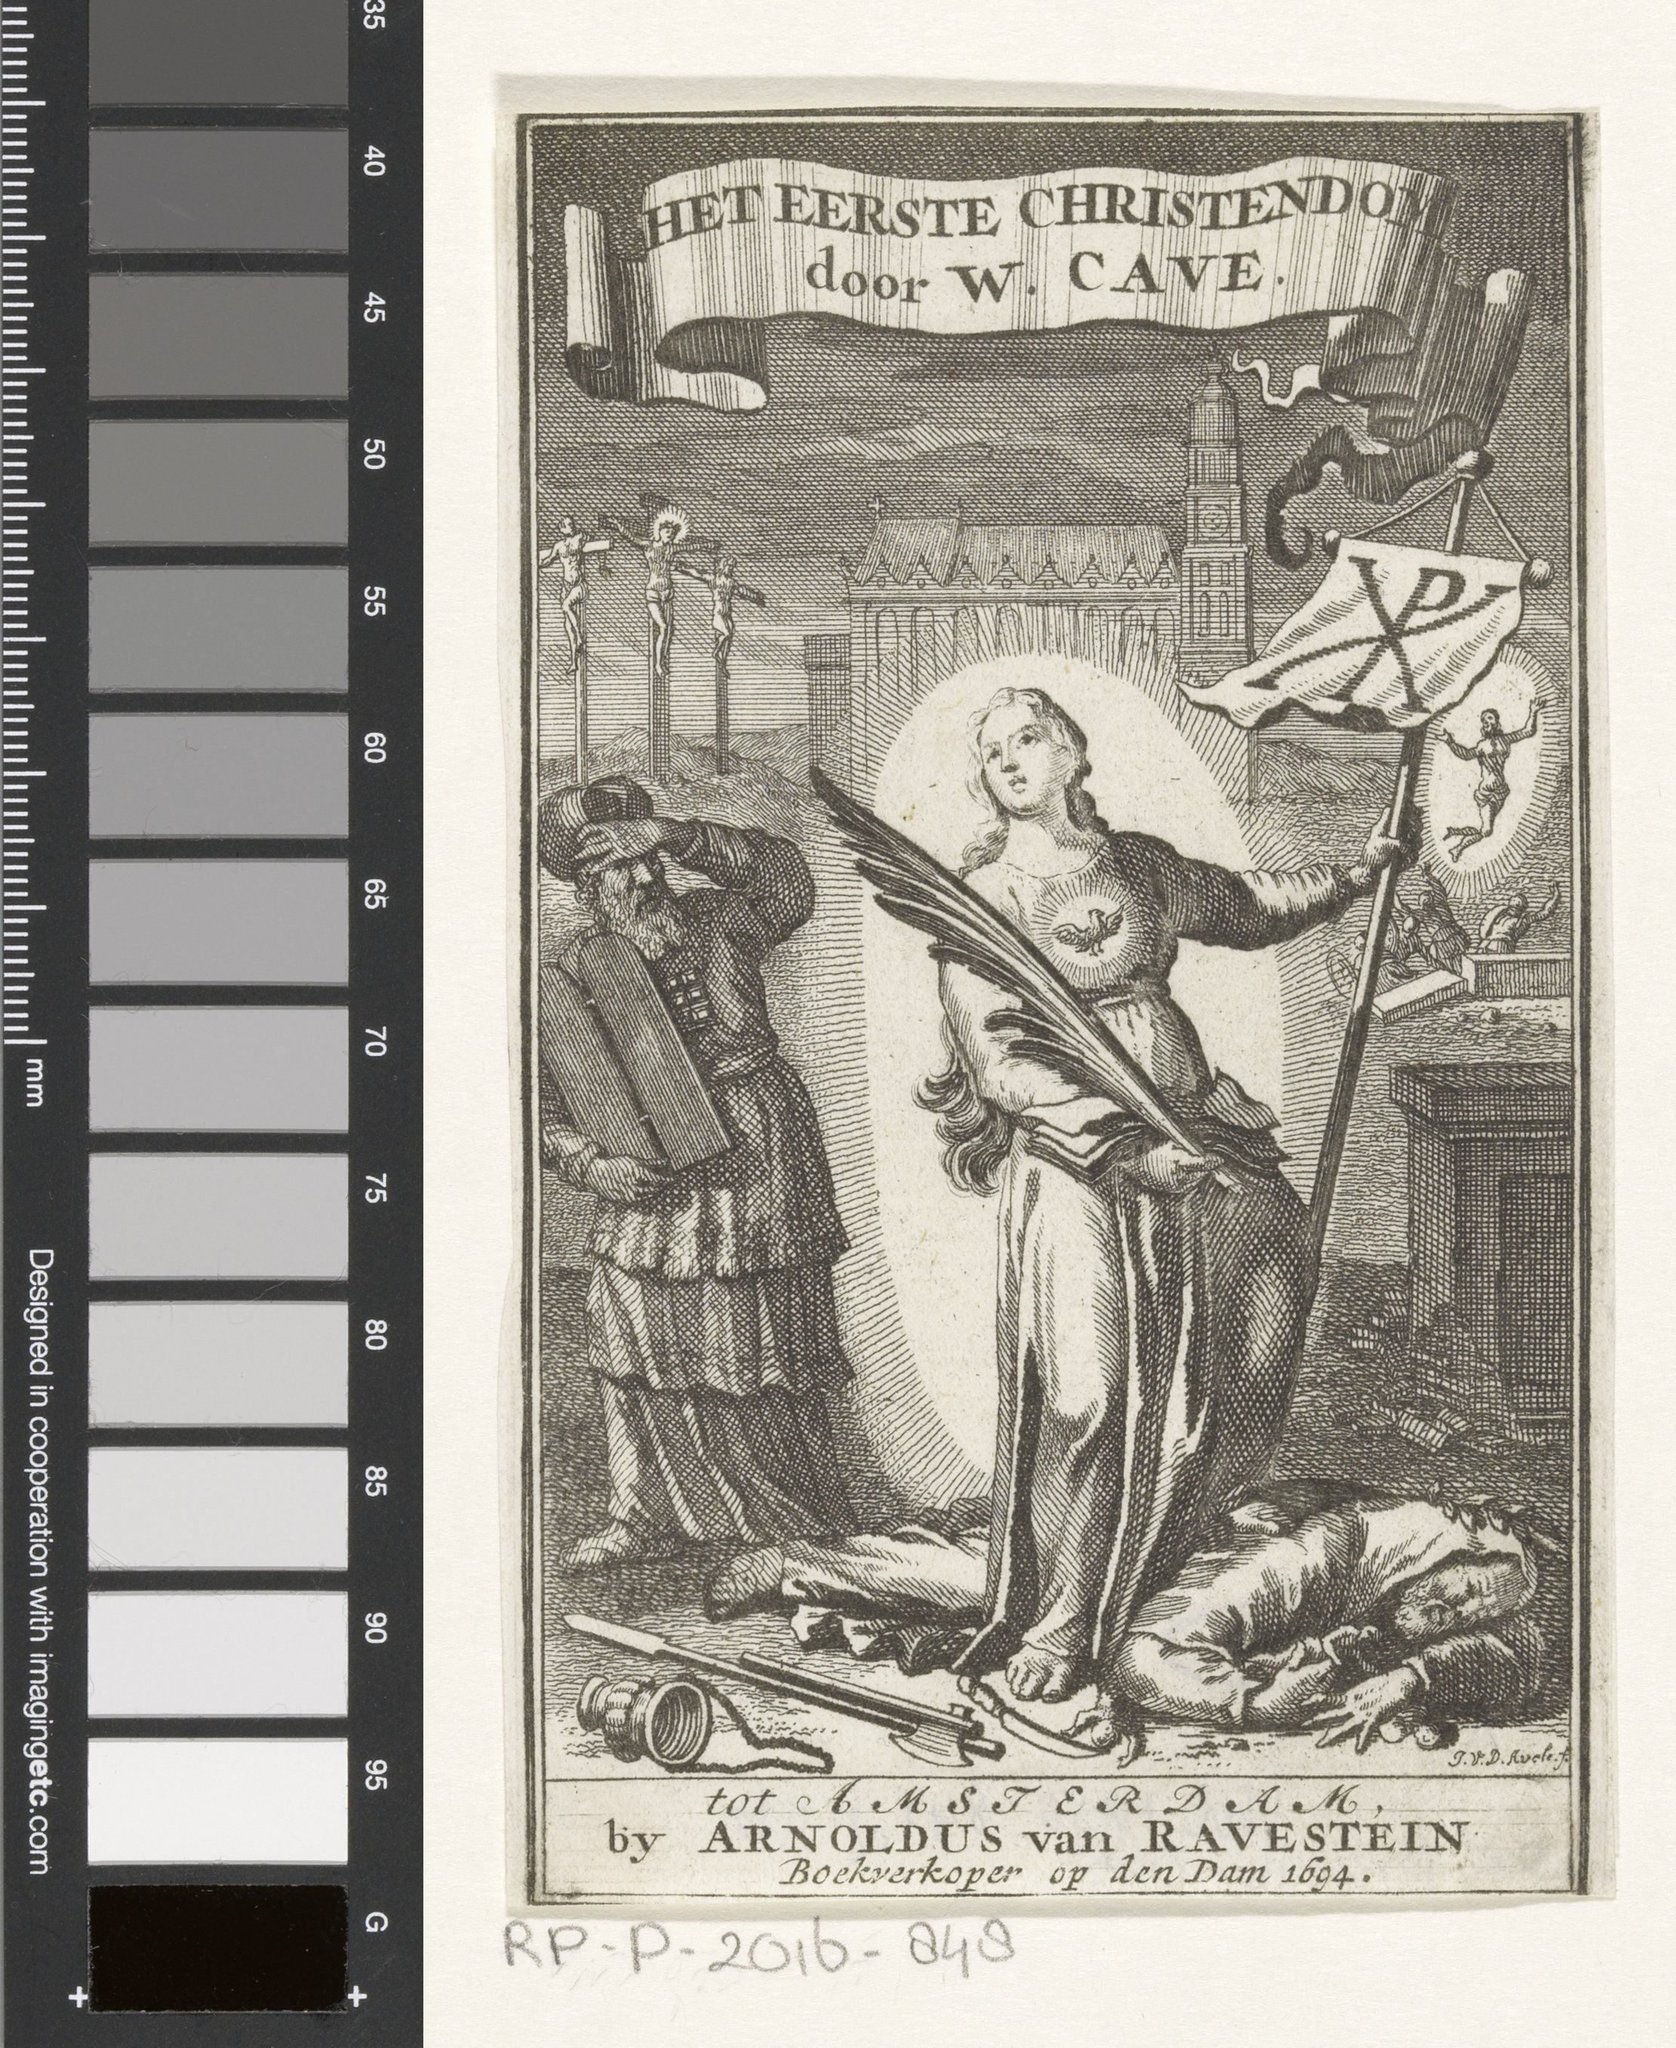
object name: print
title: Titelpagina voor: William Cave, Het eerste christendom, 1694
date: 1694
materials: paper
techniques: engraving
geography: amsterdam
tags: the church symbolized, the early christian churches, e.g. armenians, copts, syrians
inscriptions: collector's mark: Lugt 2228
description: Titelpagina voor: Cave, William. Het eerste christendom. Amsterdam: Ravestein, Arnoldus van, 1694. Prent afkomstig uit een plakalbum met titelprenten, ornamenten etc. op blauw papier in 1983 uit elkaar gehaald. Volgens een notitie op verso zat de prent op p. 116 van dit album.